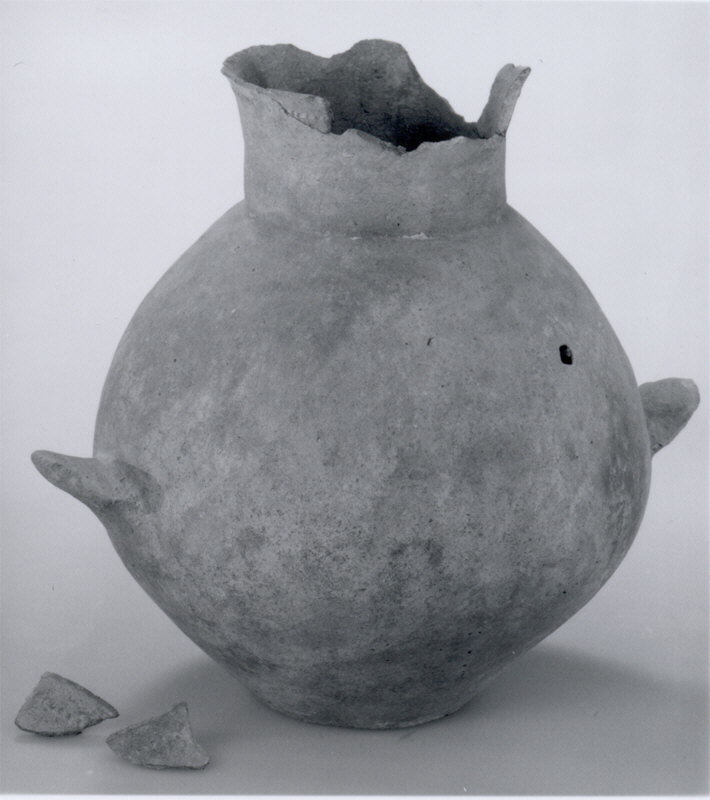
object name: jar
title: Jar with ledge handles and punctate decoration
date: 3500-3300 BCE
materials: ceramic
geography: levant